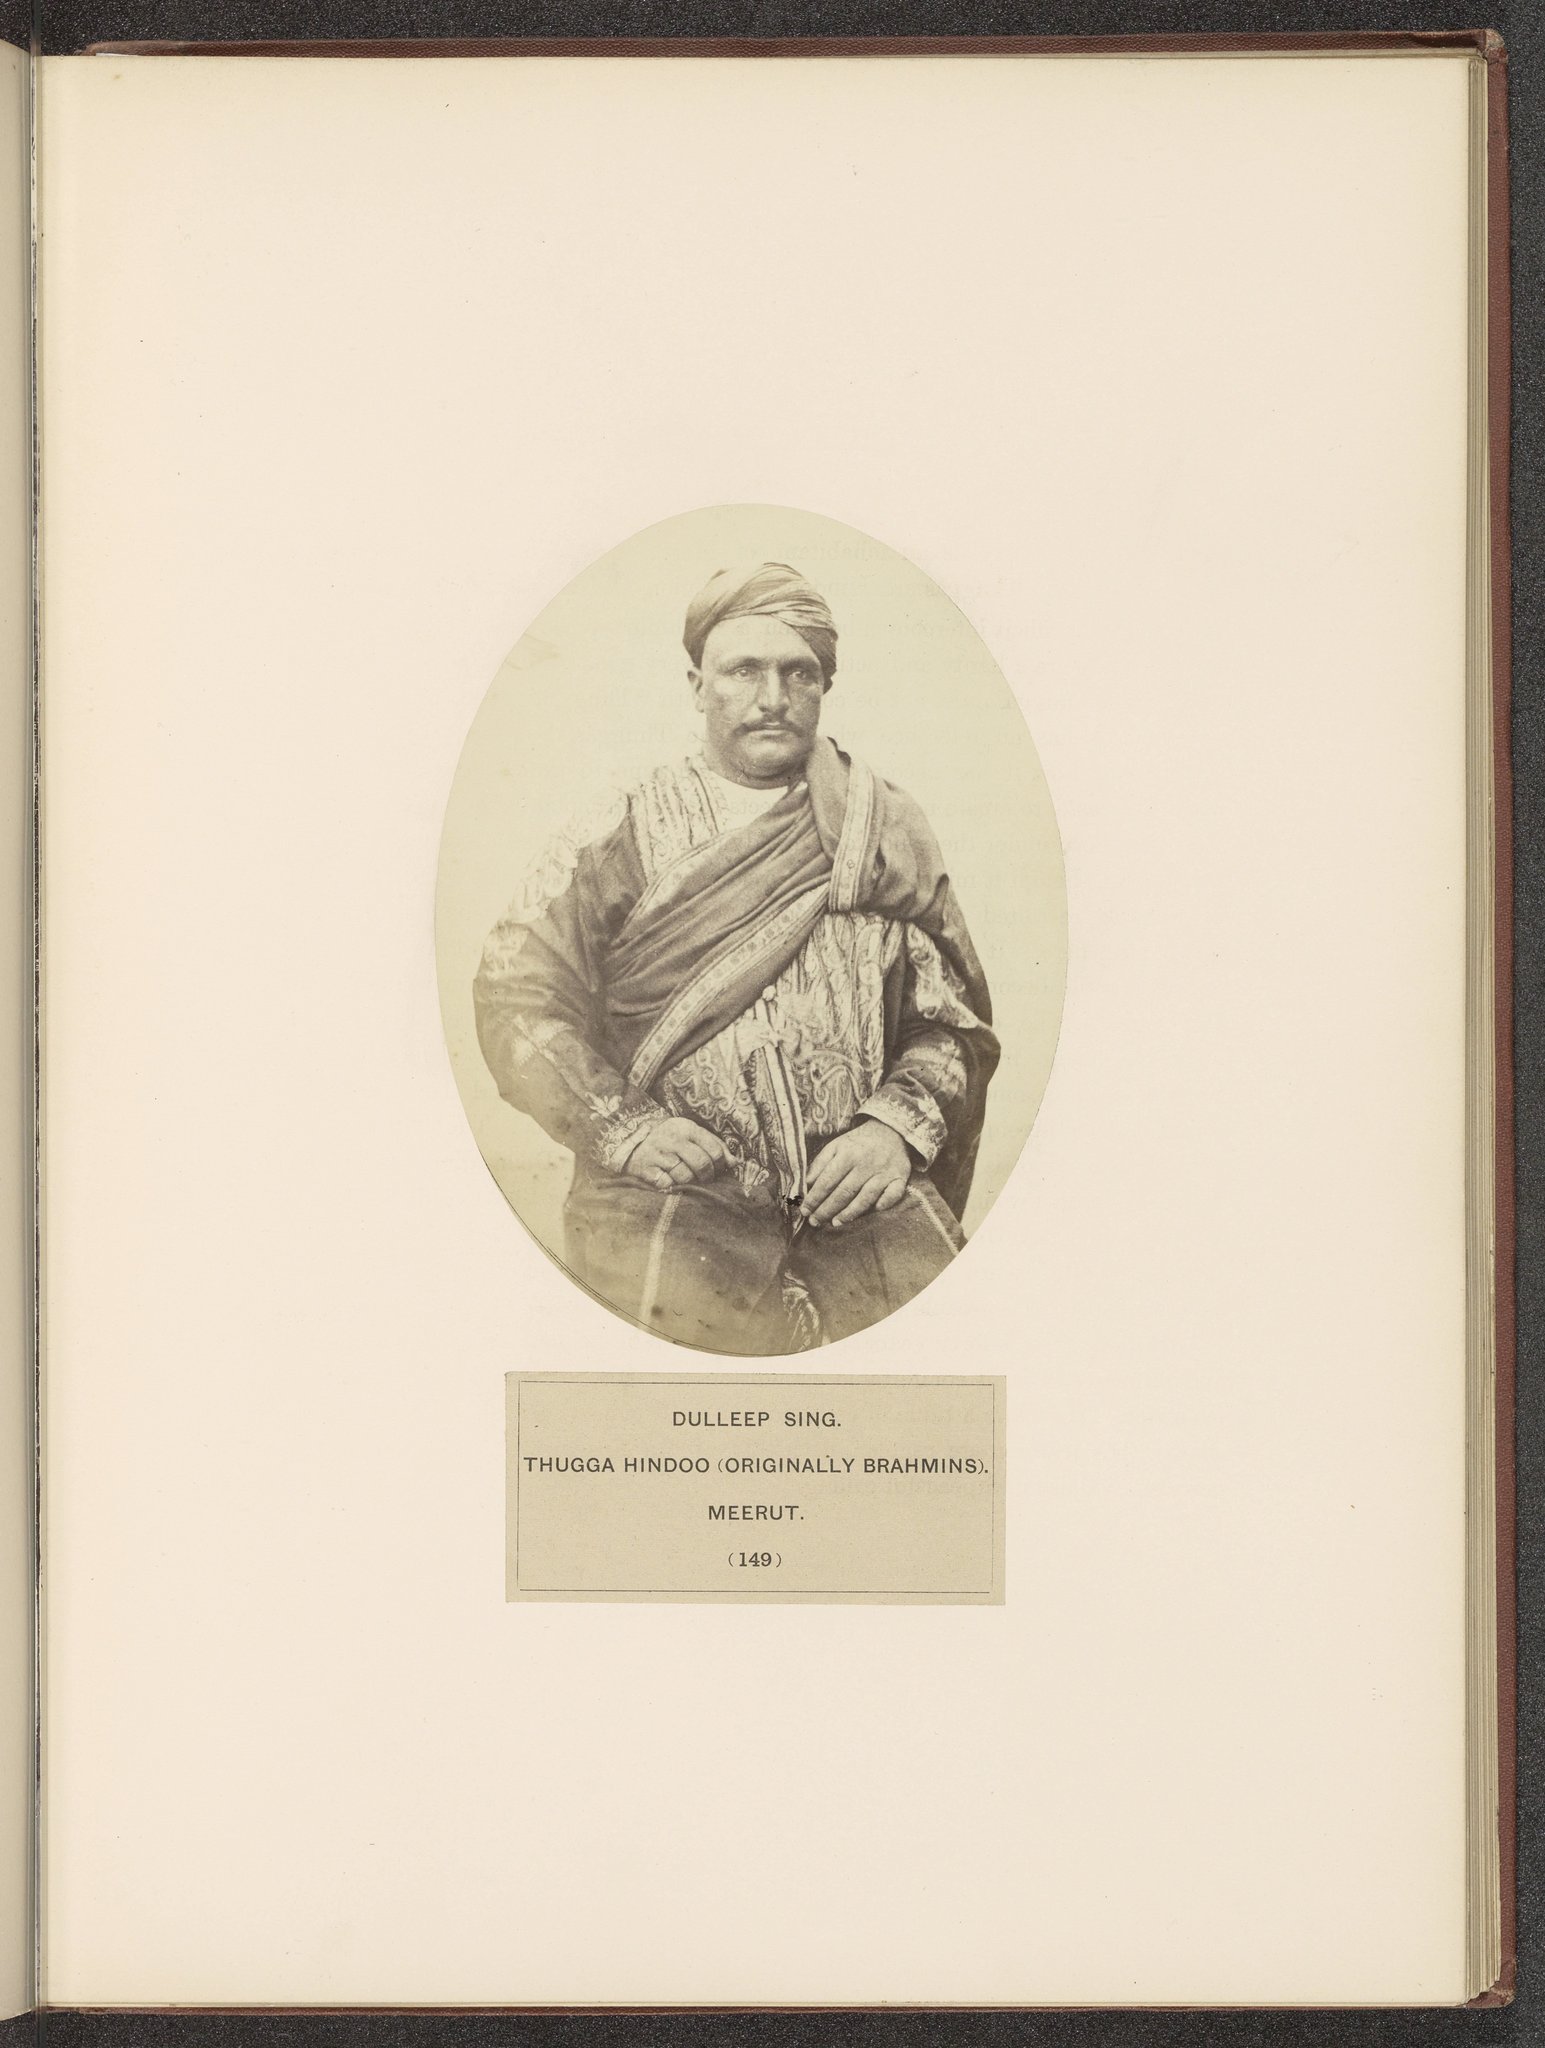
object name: page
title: Portrait of Dulleep Sing, a landholder and farmer from Meerut, Uttar Pradesh, India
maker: Anonymous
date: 1858-1868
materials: photographic support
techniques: albumen print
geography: meerut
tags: head-gear: turban, human races; peoples; nationalities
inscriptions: number: ‘(149)’, inscription: ‘DULLEEP SING./ THUGGA HINDOO (ORIGINALLY BRAHMINS)./ MEERUT.’